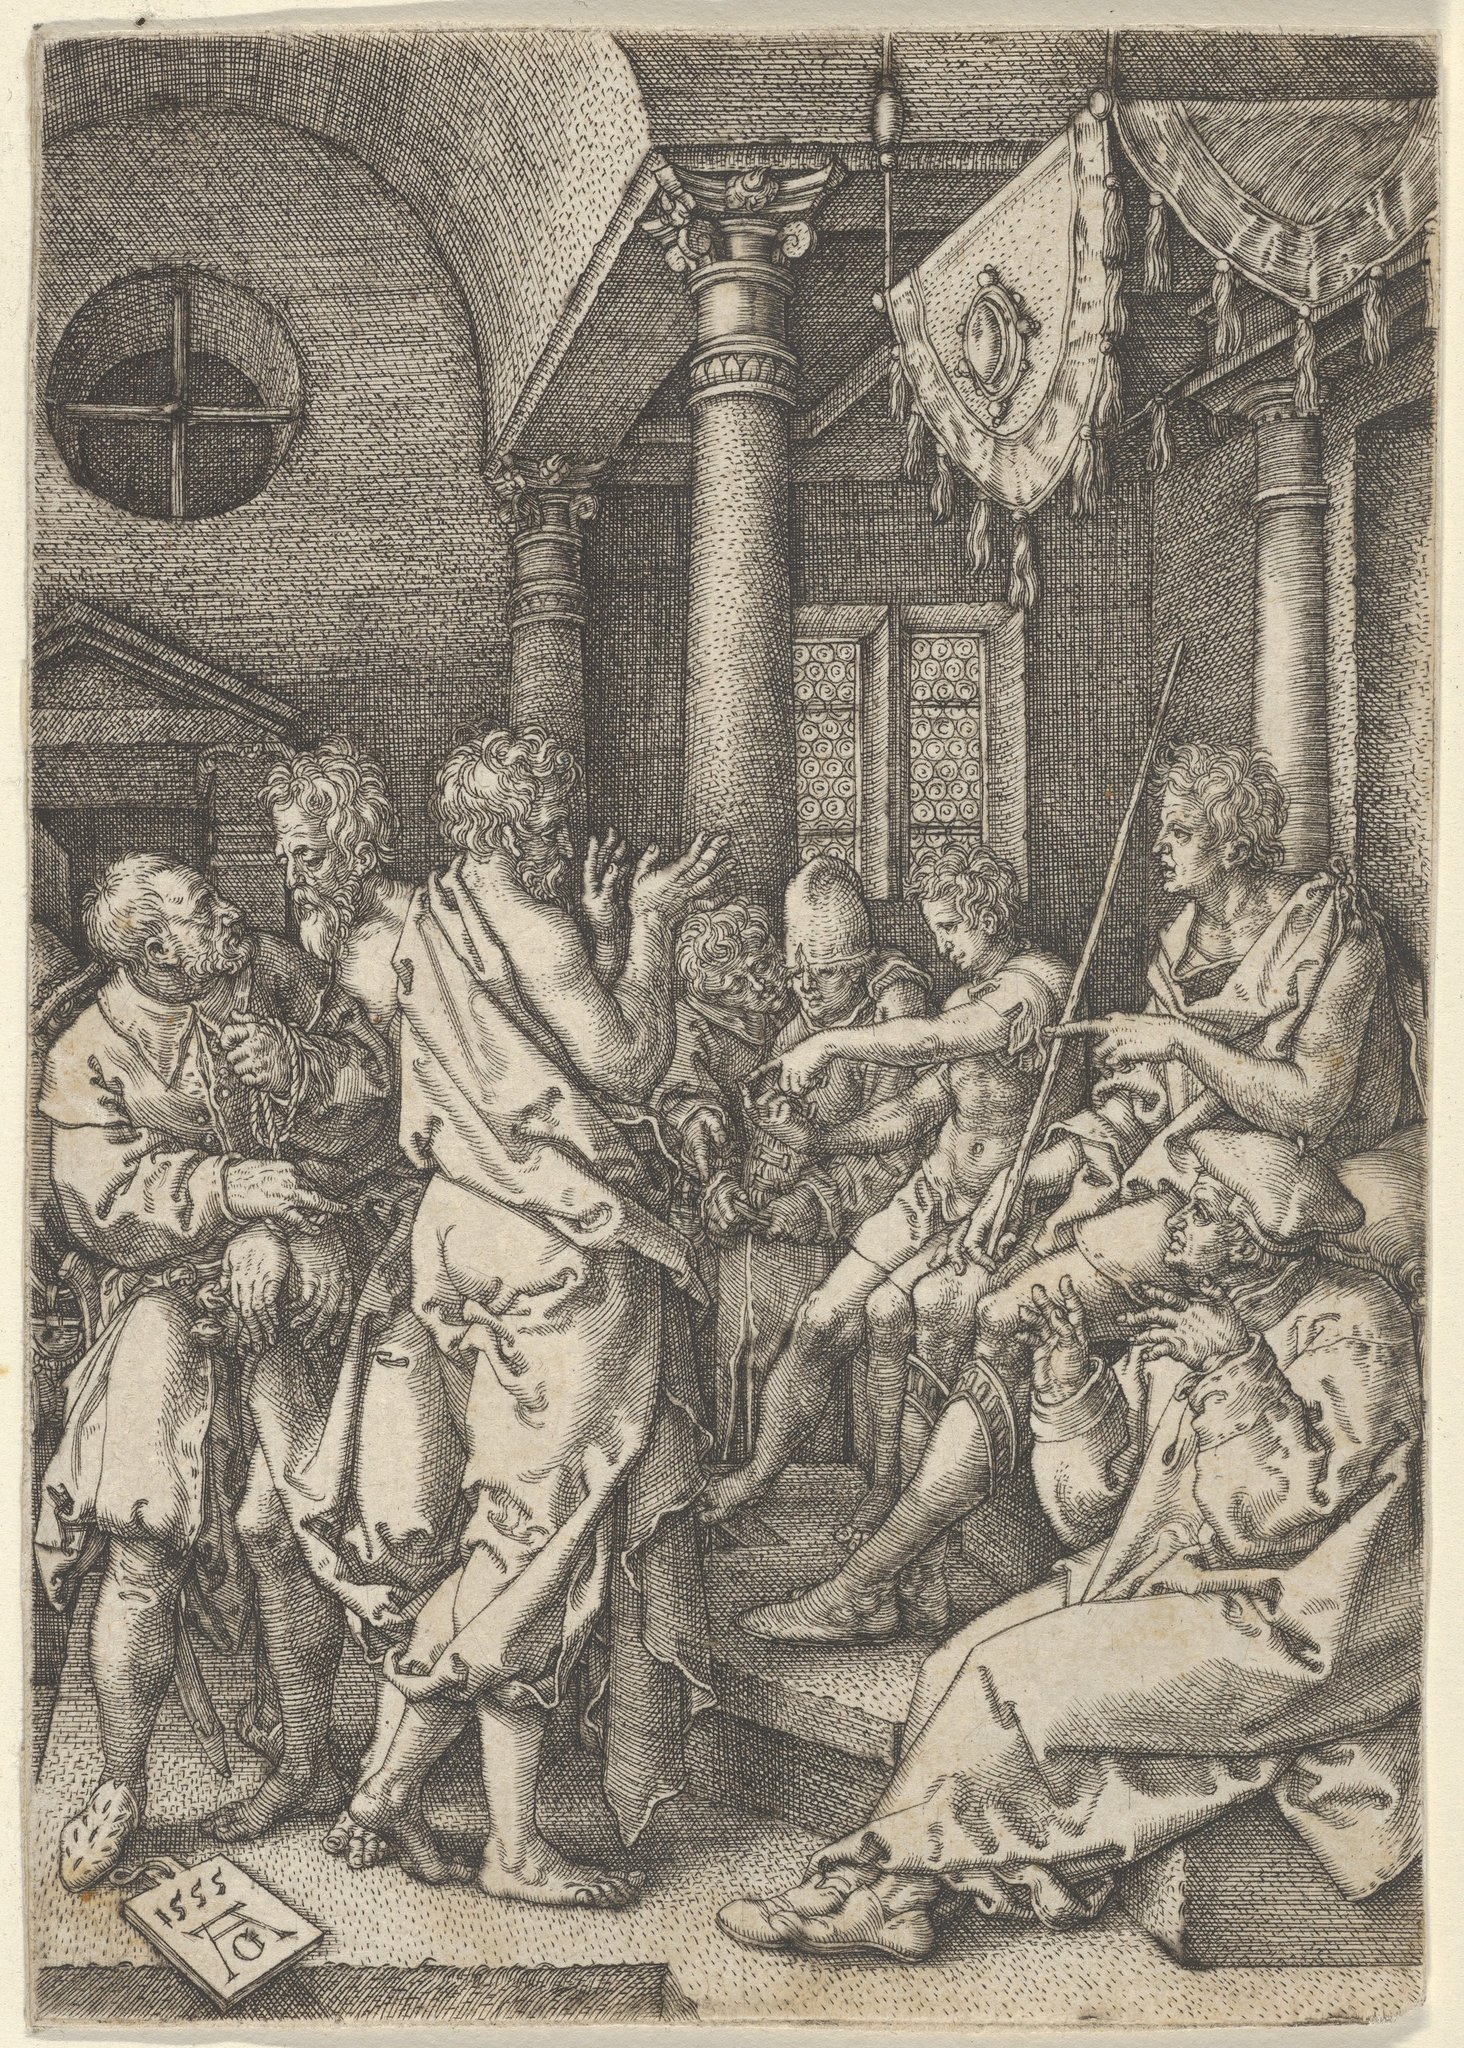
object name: print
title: Daniel Cross-Examining the Elders, from "The Story of Susanna"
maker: heinrich aldegrever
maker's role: artist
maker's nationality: german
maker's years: 1502-1561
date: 1555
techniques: engraving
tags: soldiers,men